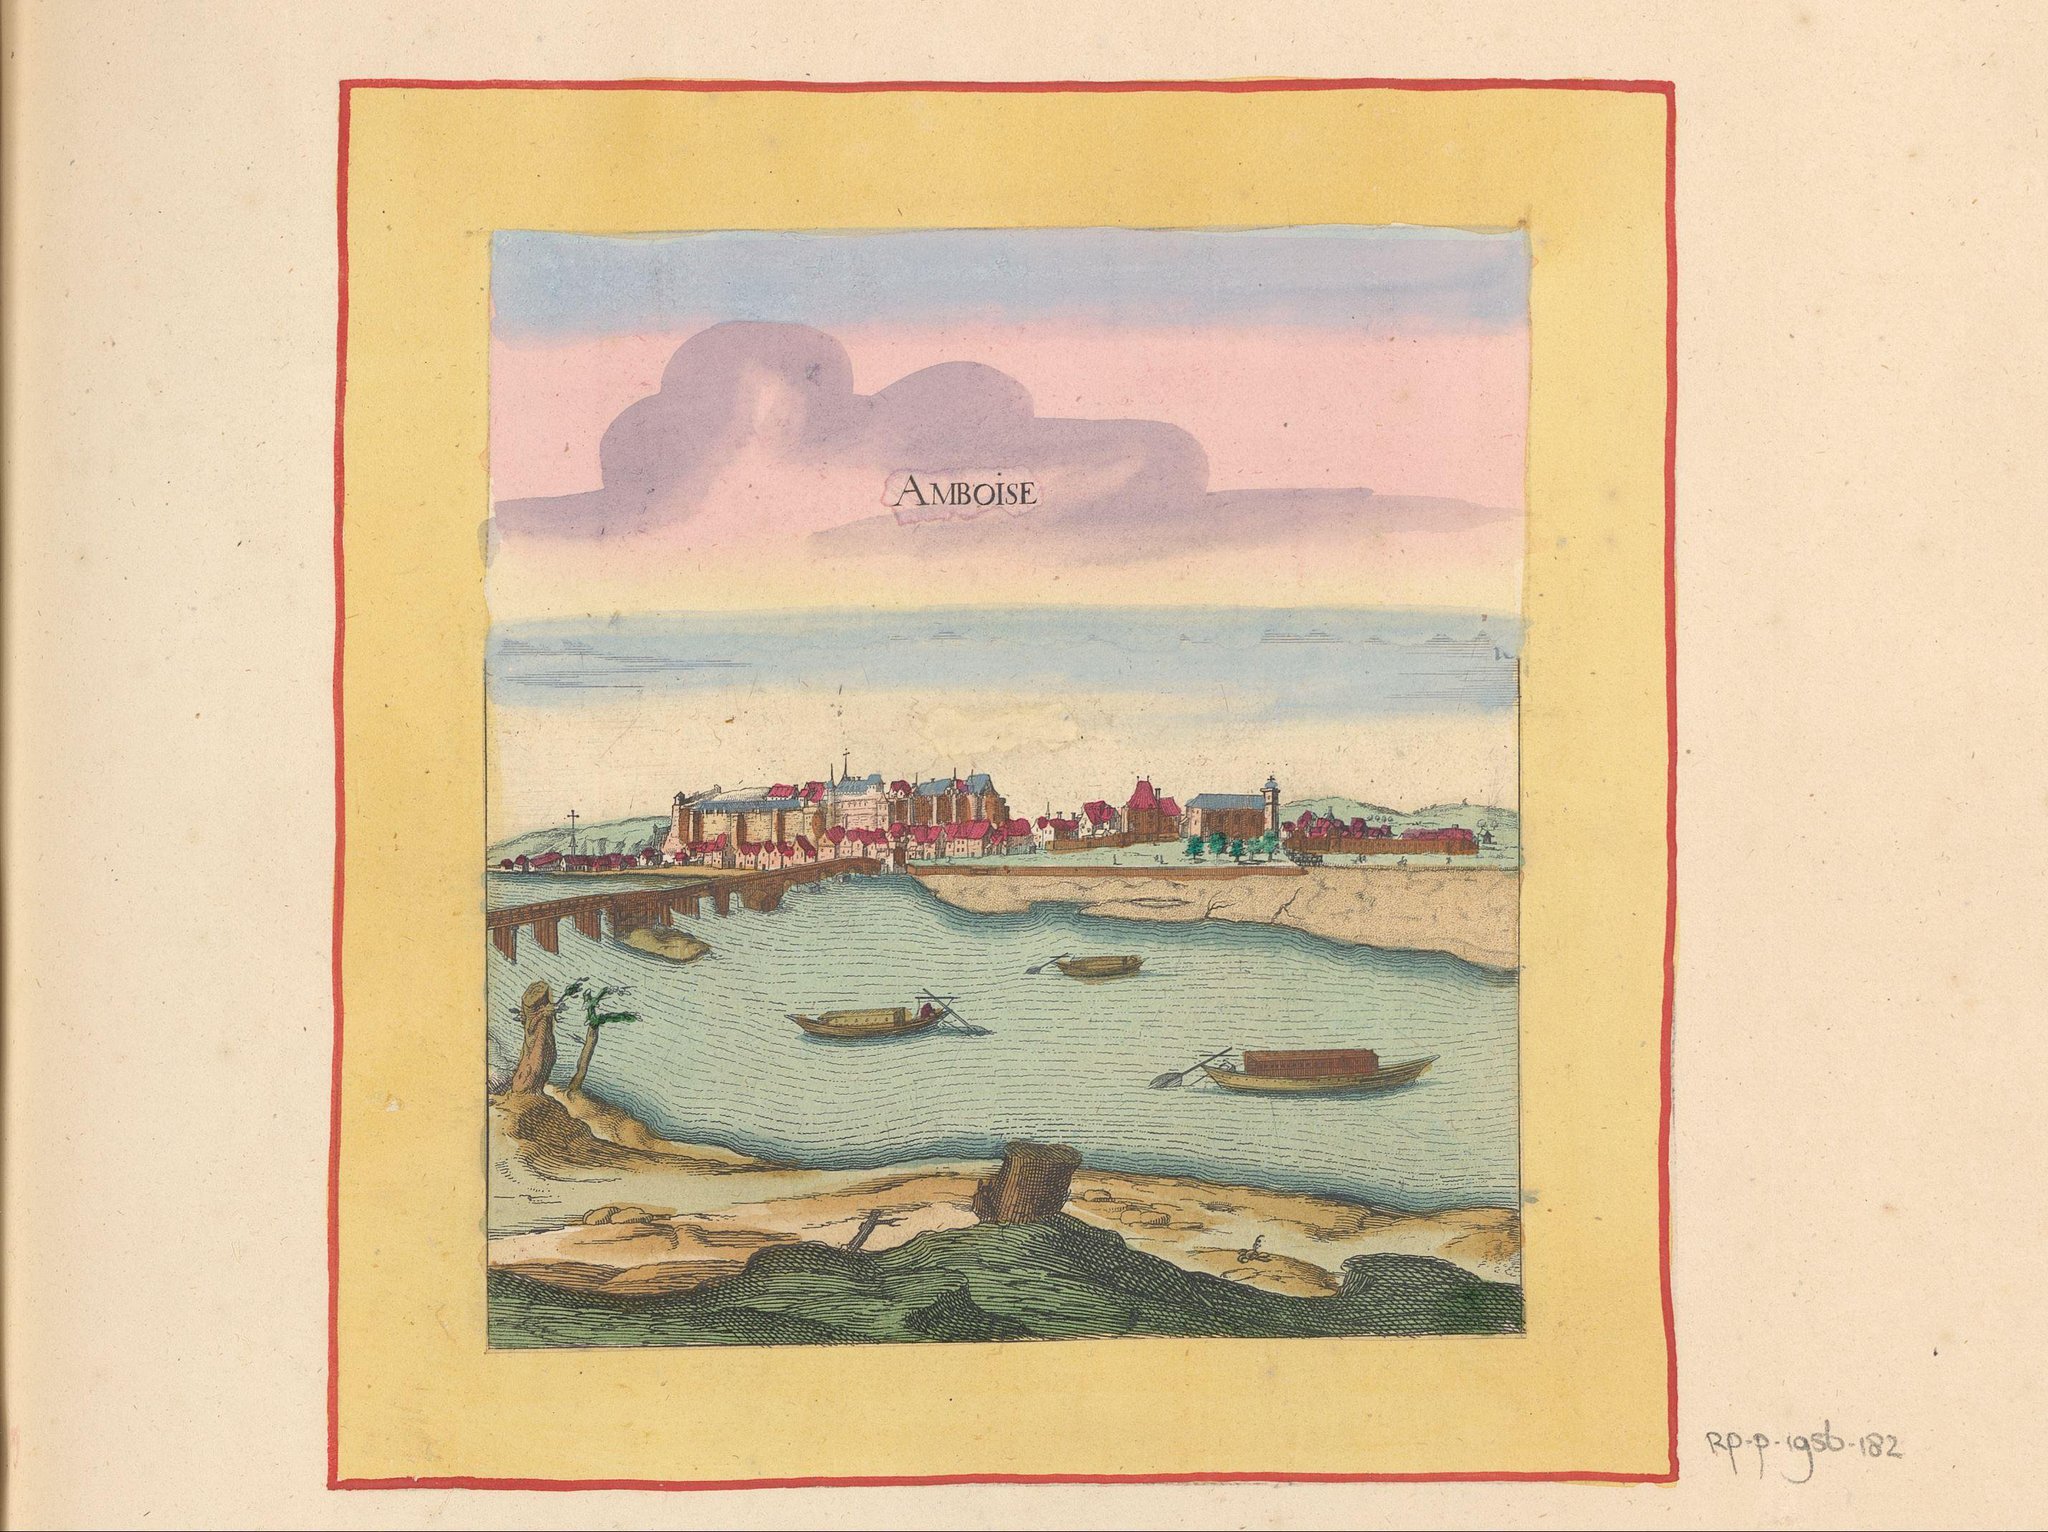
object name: album leaf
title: Amboise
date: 1657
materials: paper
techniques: engraving, etching, hand coloring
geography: paris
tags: city-view in general; 'veduta'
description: Prent uit: Tassin, Christophe. Les plans et profils de toutes les principales villes et lieux considérables de France (...). Parijs: Michel van Lochom, 1638, prent nummer 16 in het deel 'Loire'.